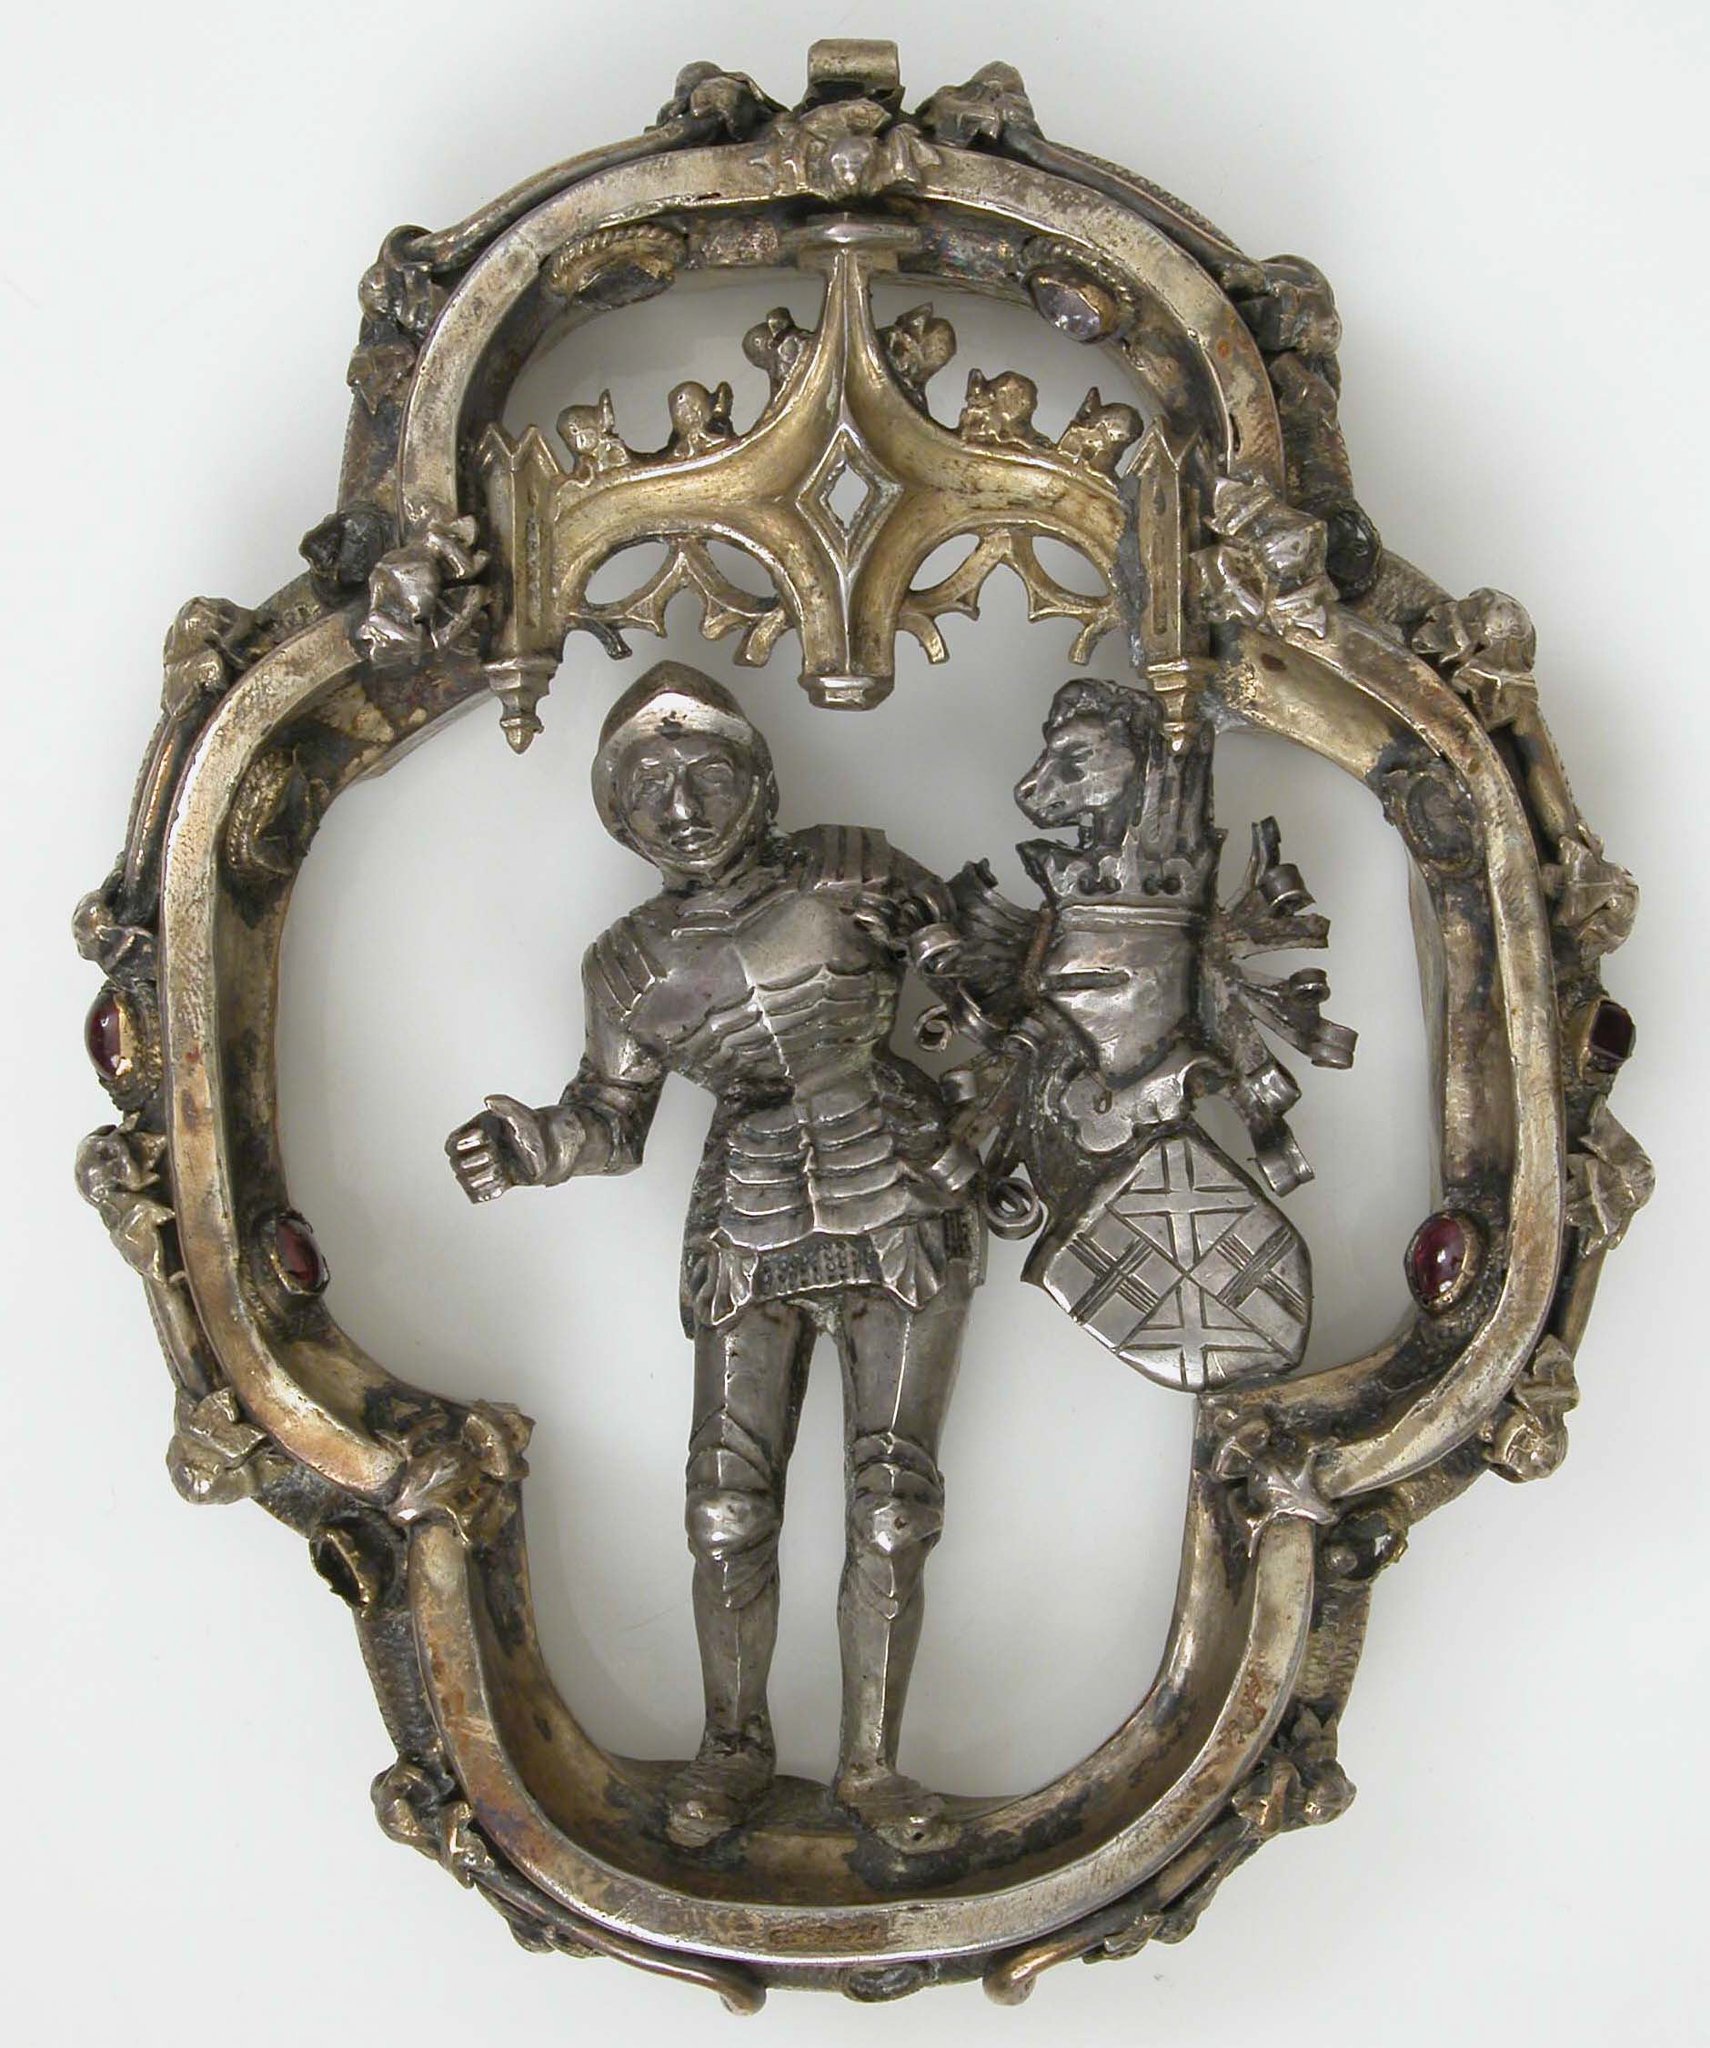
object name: pendant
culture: german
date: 1801-1900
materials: garnet, gilt, glass, silver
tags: men,coat of arms